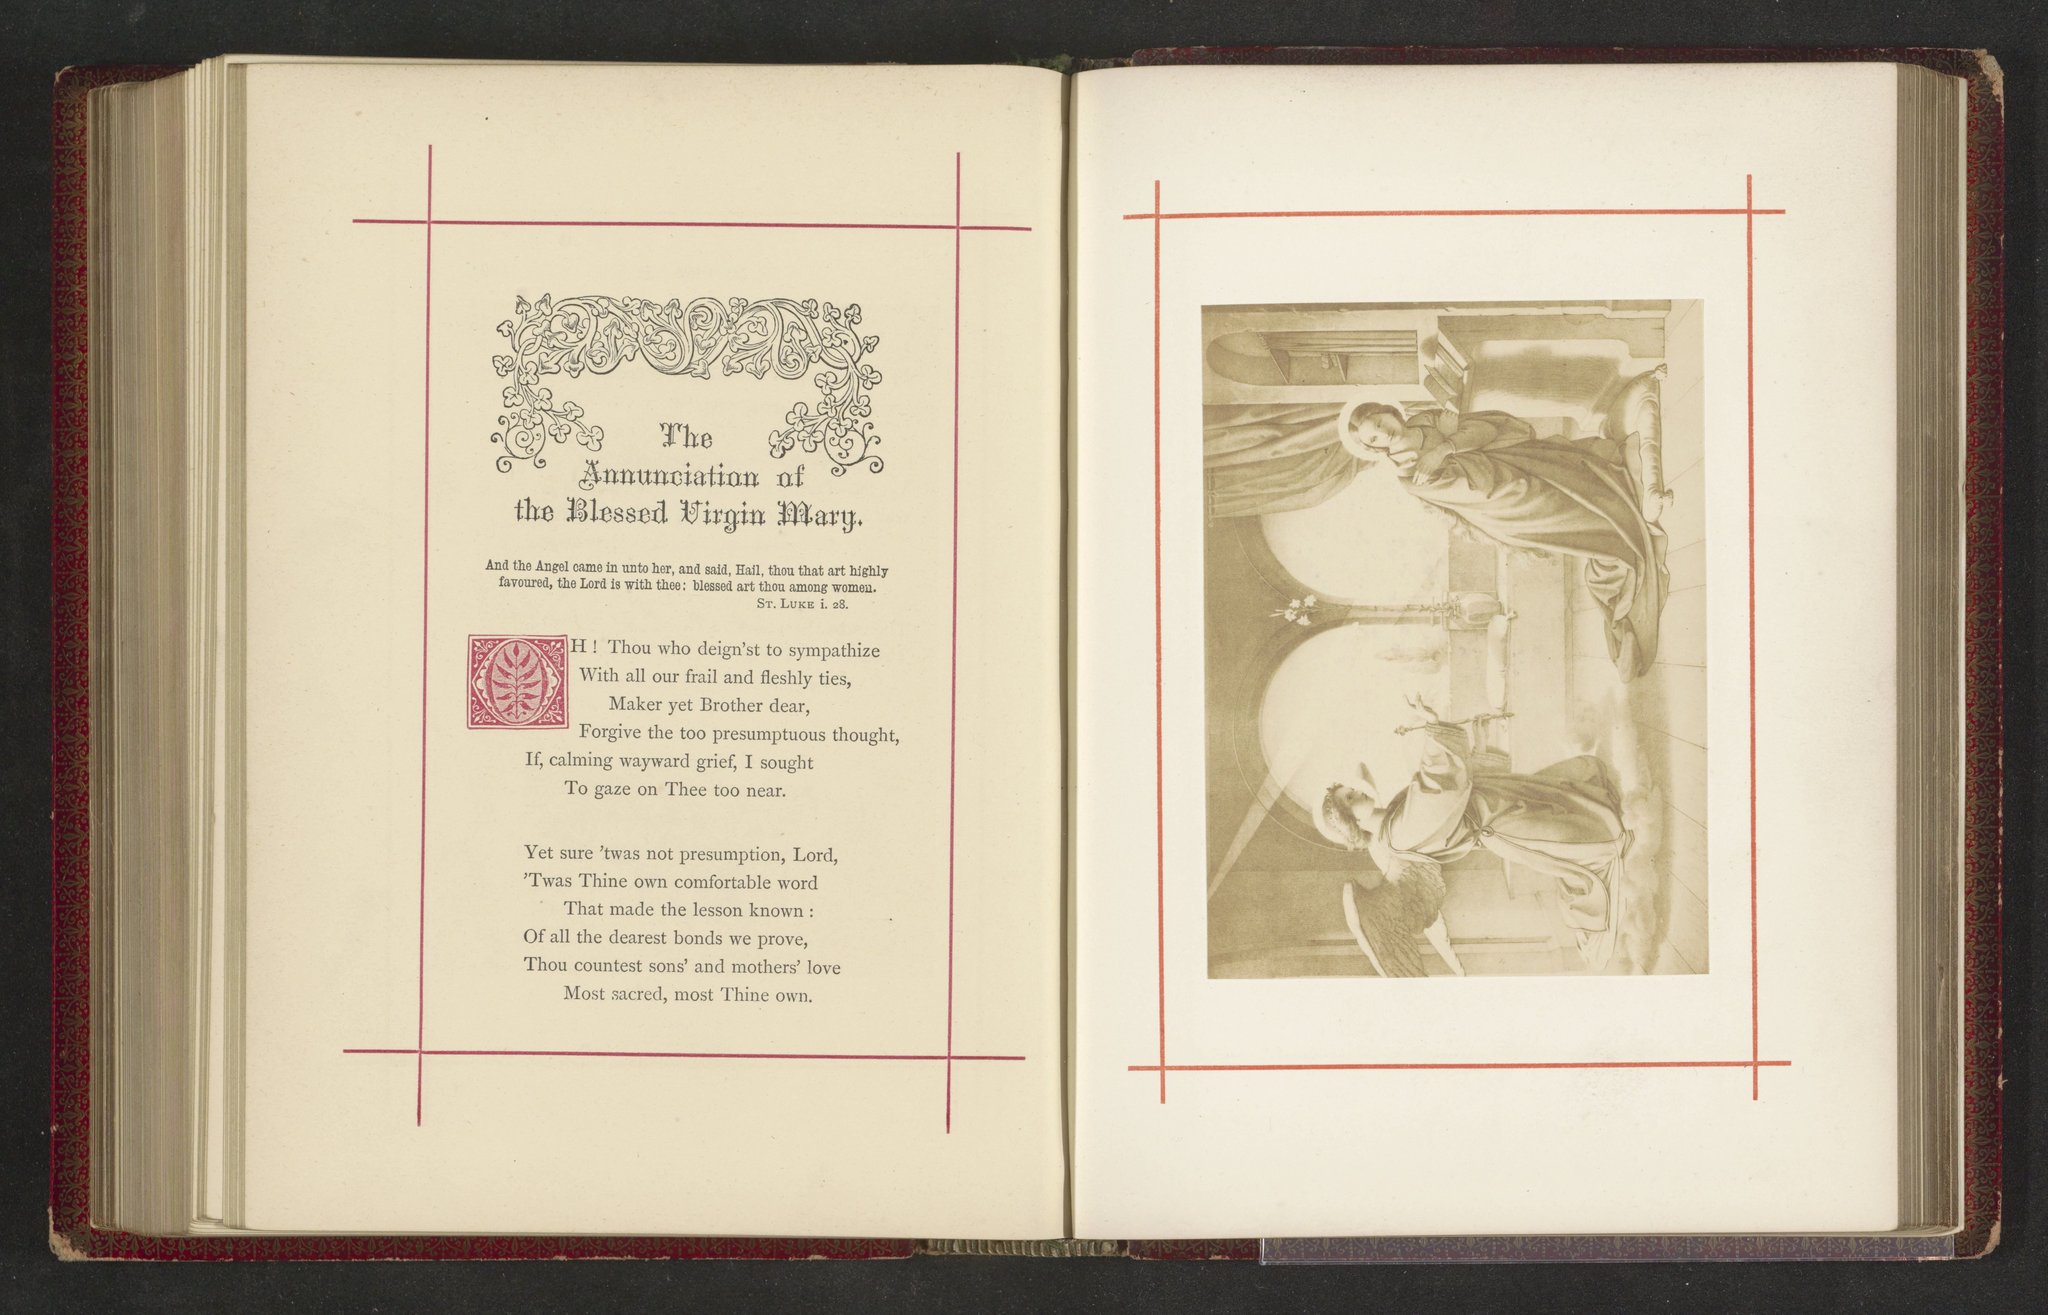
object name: photograph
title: Fotoreproductie van een prent, voorstellende de Annunciatie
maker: Anonymous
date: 1868-1873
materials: photographic support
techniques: albumen print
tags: the annunciation: mary kneeling